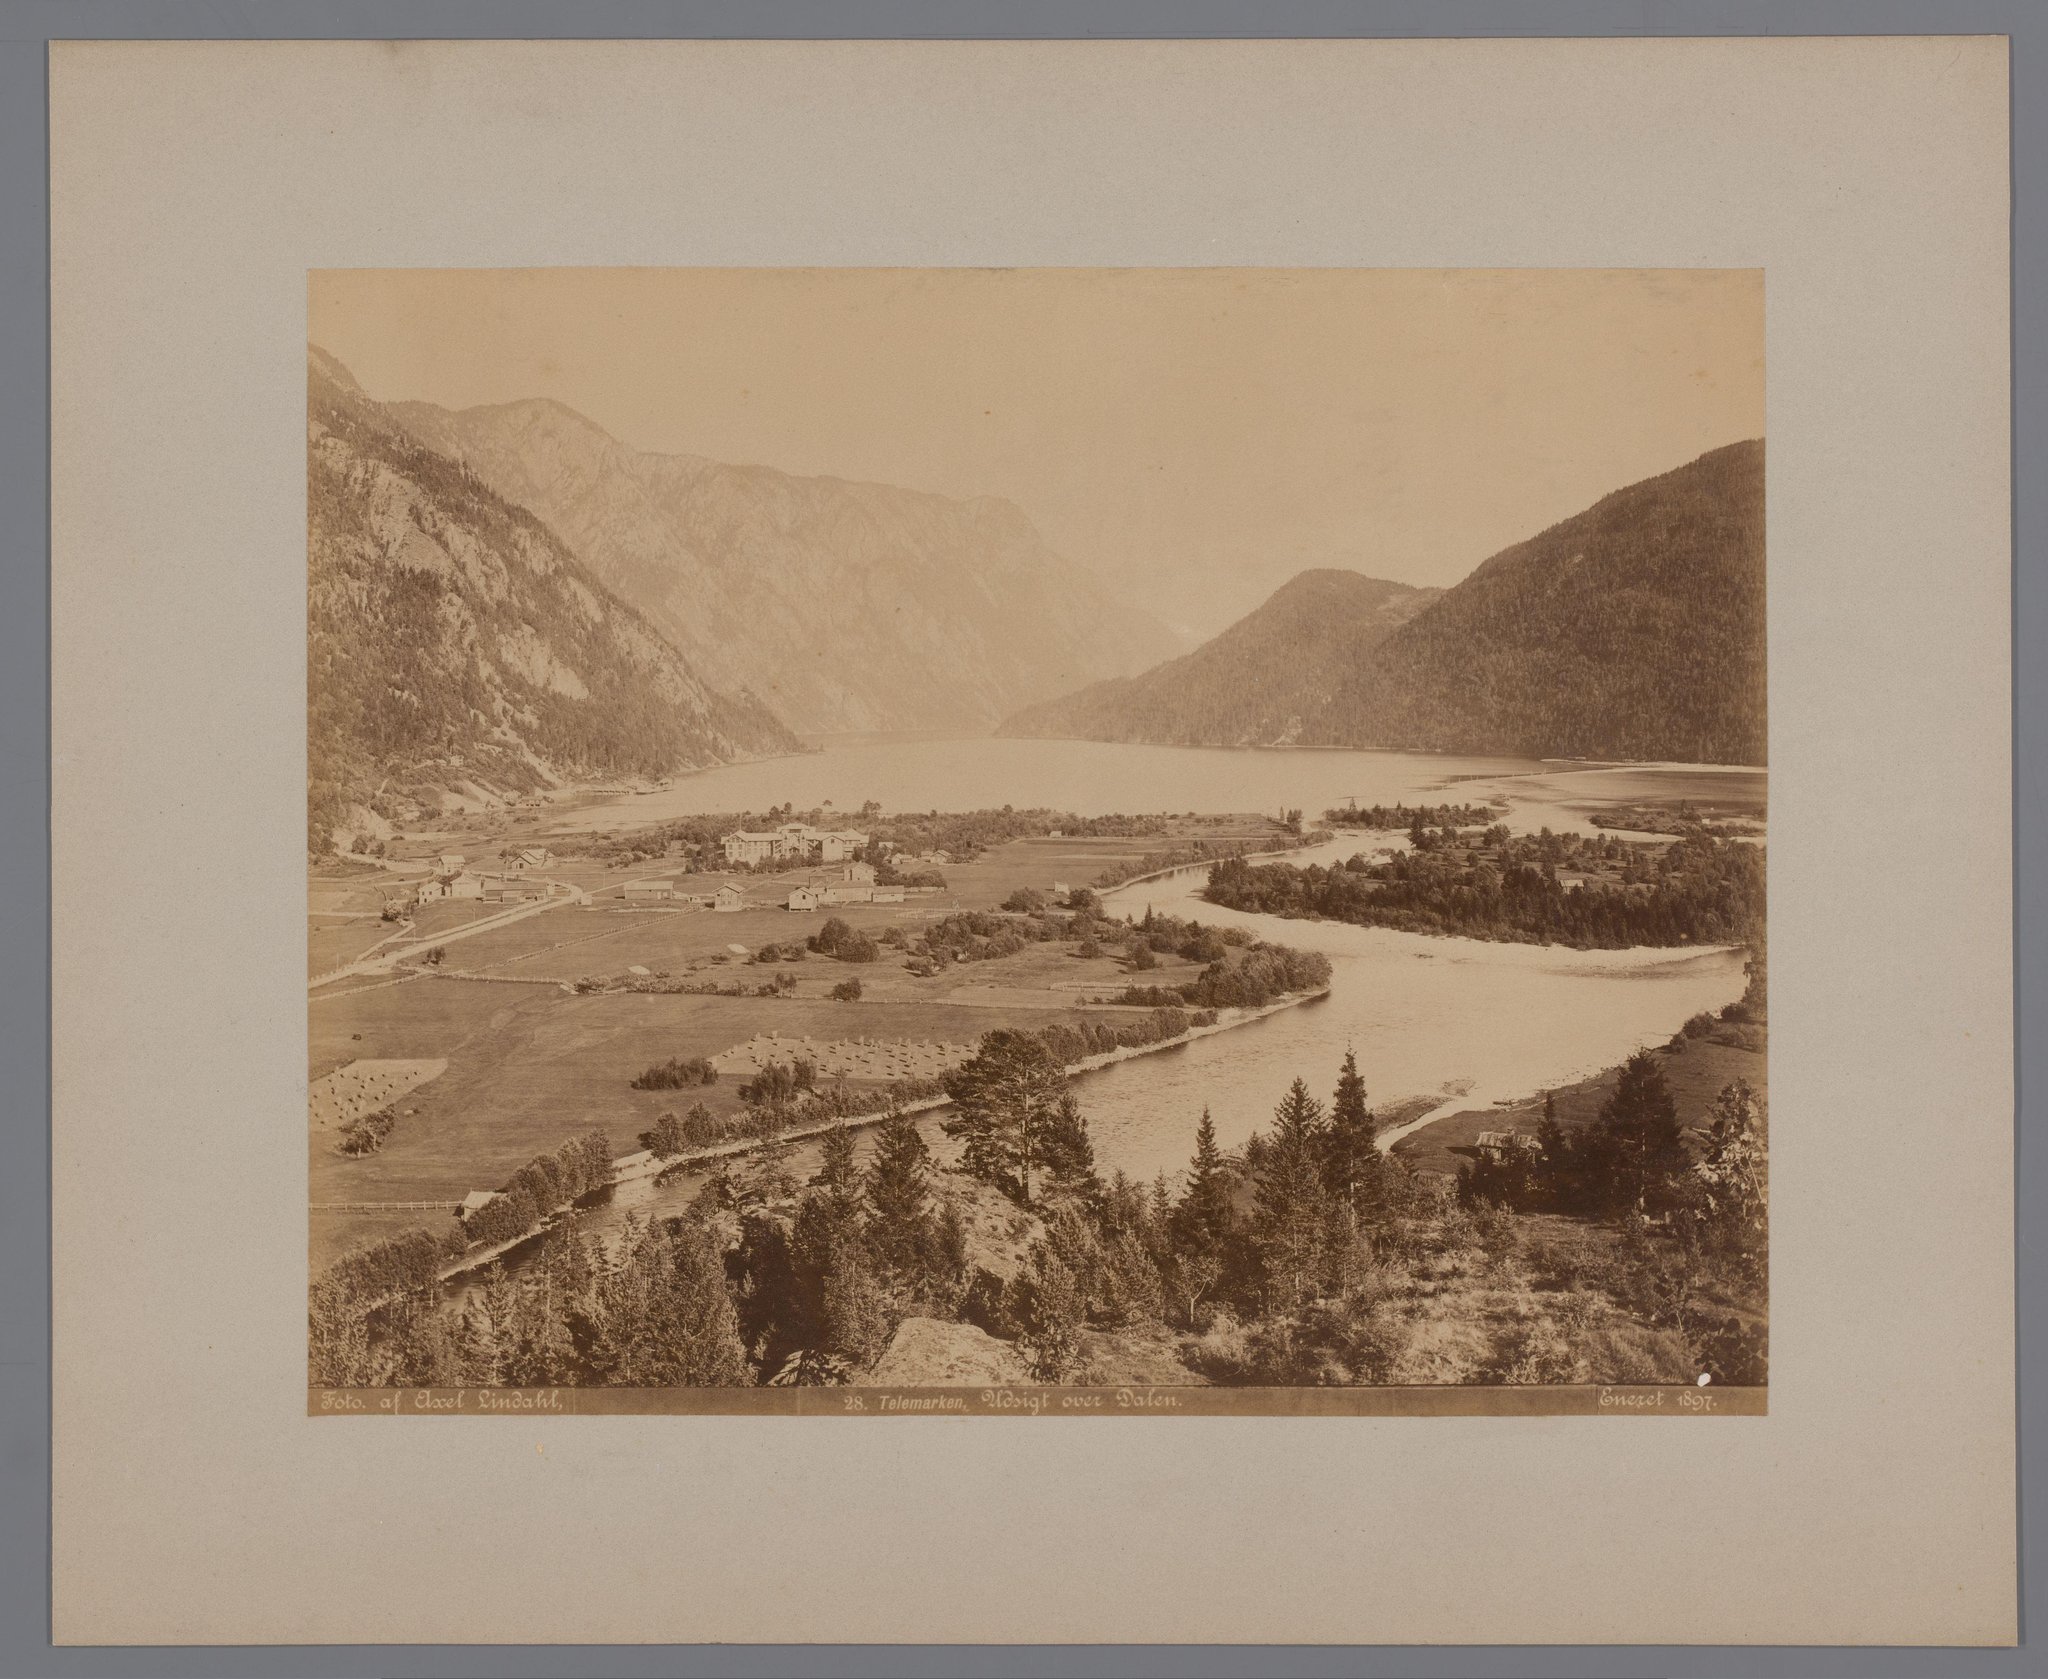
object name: photograph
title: Uitzicht over Dalen, Telemarken, Noorwegen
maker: axel lindahl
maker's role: fotograaf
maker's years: 1841-1906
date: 1897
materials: cardboard, photographic support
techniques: albumen print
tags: norway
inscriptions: date: ‘Eneret 1897.’, inscription: ‘28. Telemarken, Udzigt over Dalen.’, caption: ‘Foto, af Axel Lindahl,’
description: Uitzicht over Dalen, Telemarken, Noorwegen.